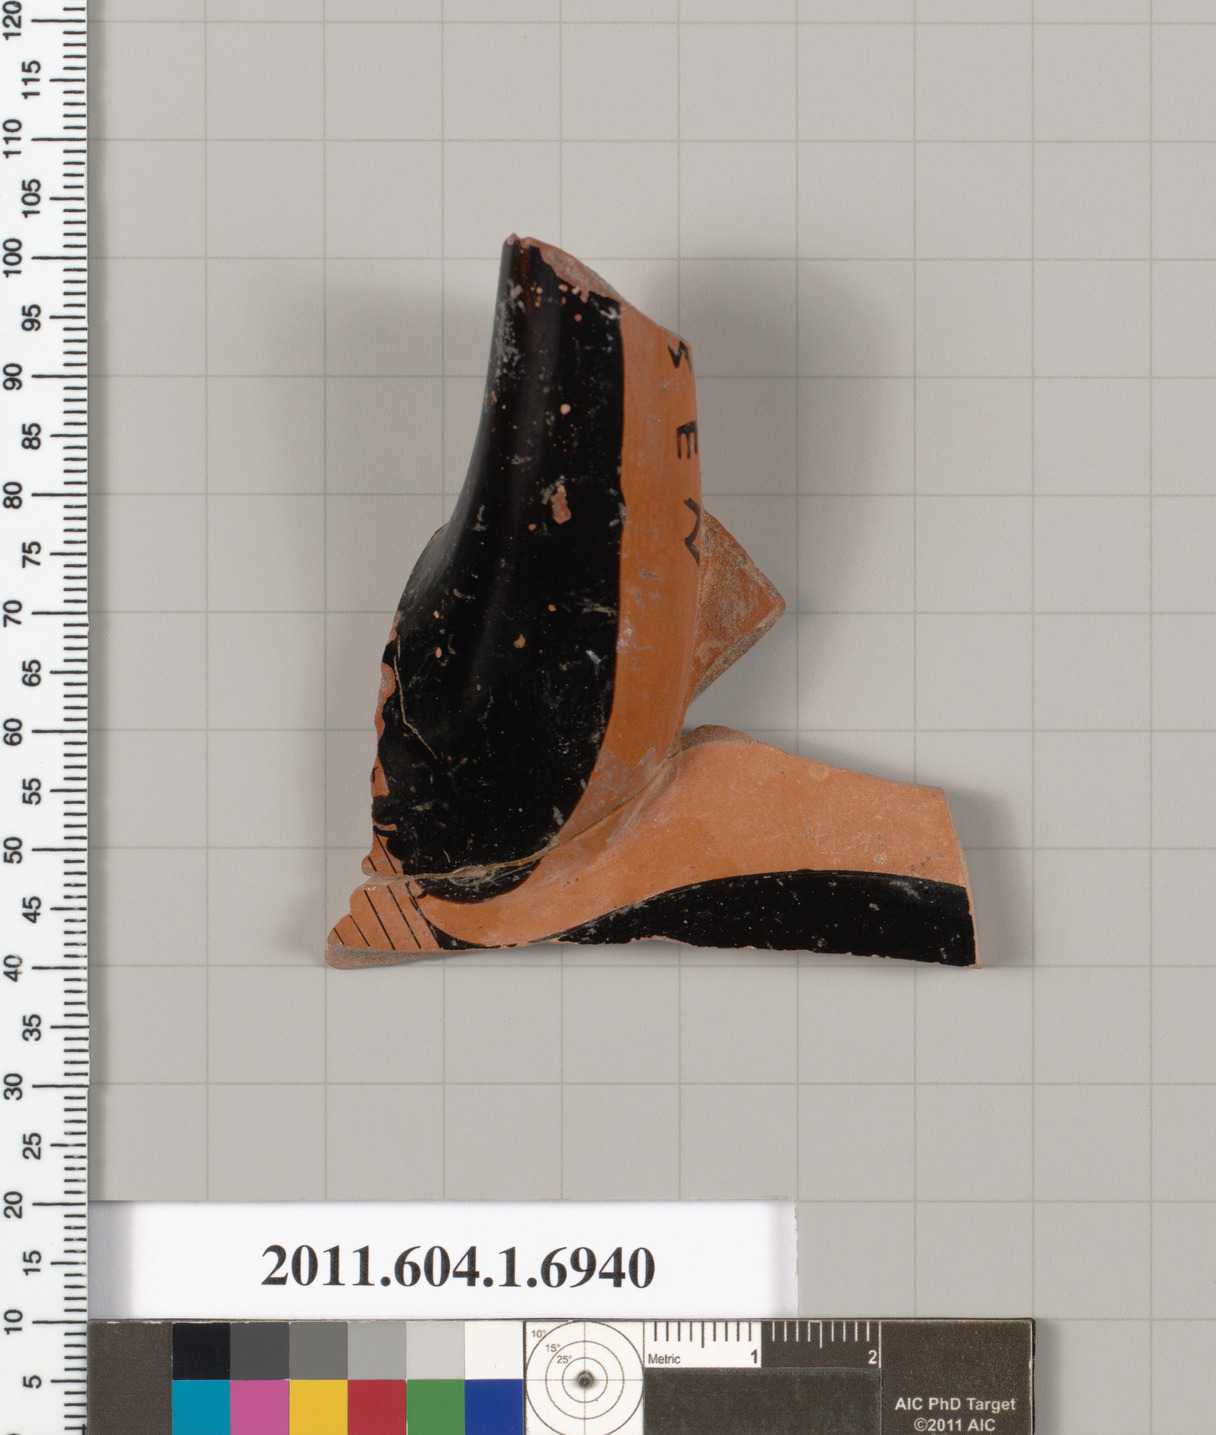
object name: kylix fragment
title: Terracotta fragment of a kylix (drinking cup)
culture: greek, attic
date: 490-470 BCE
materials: terracotta